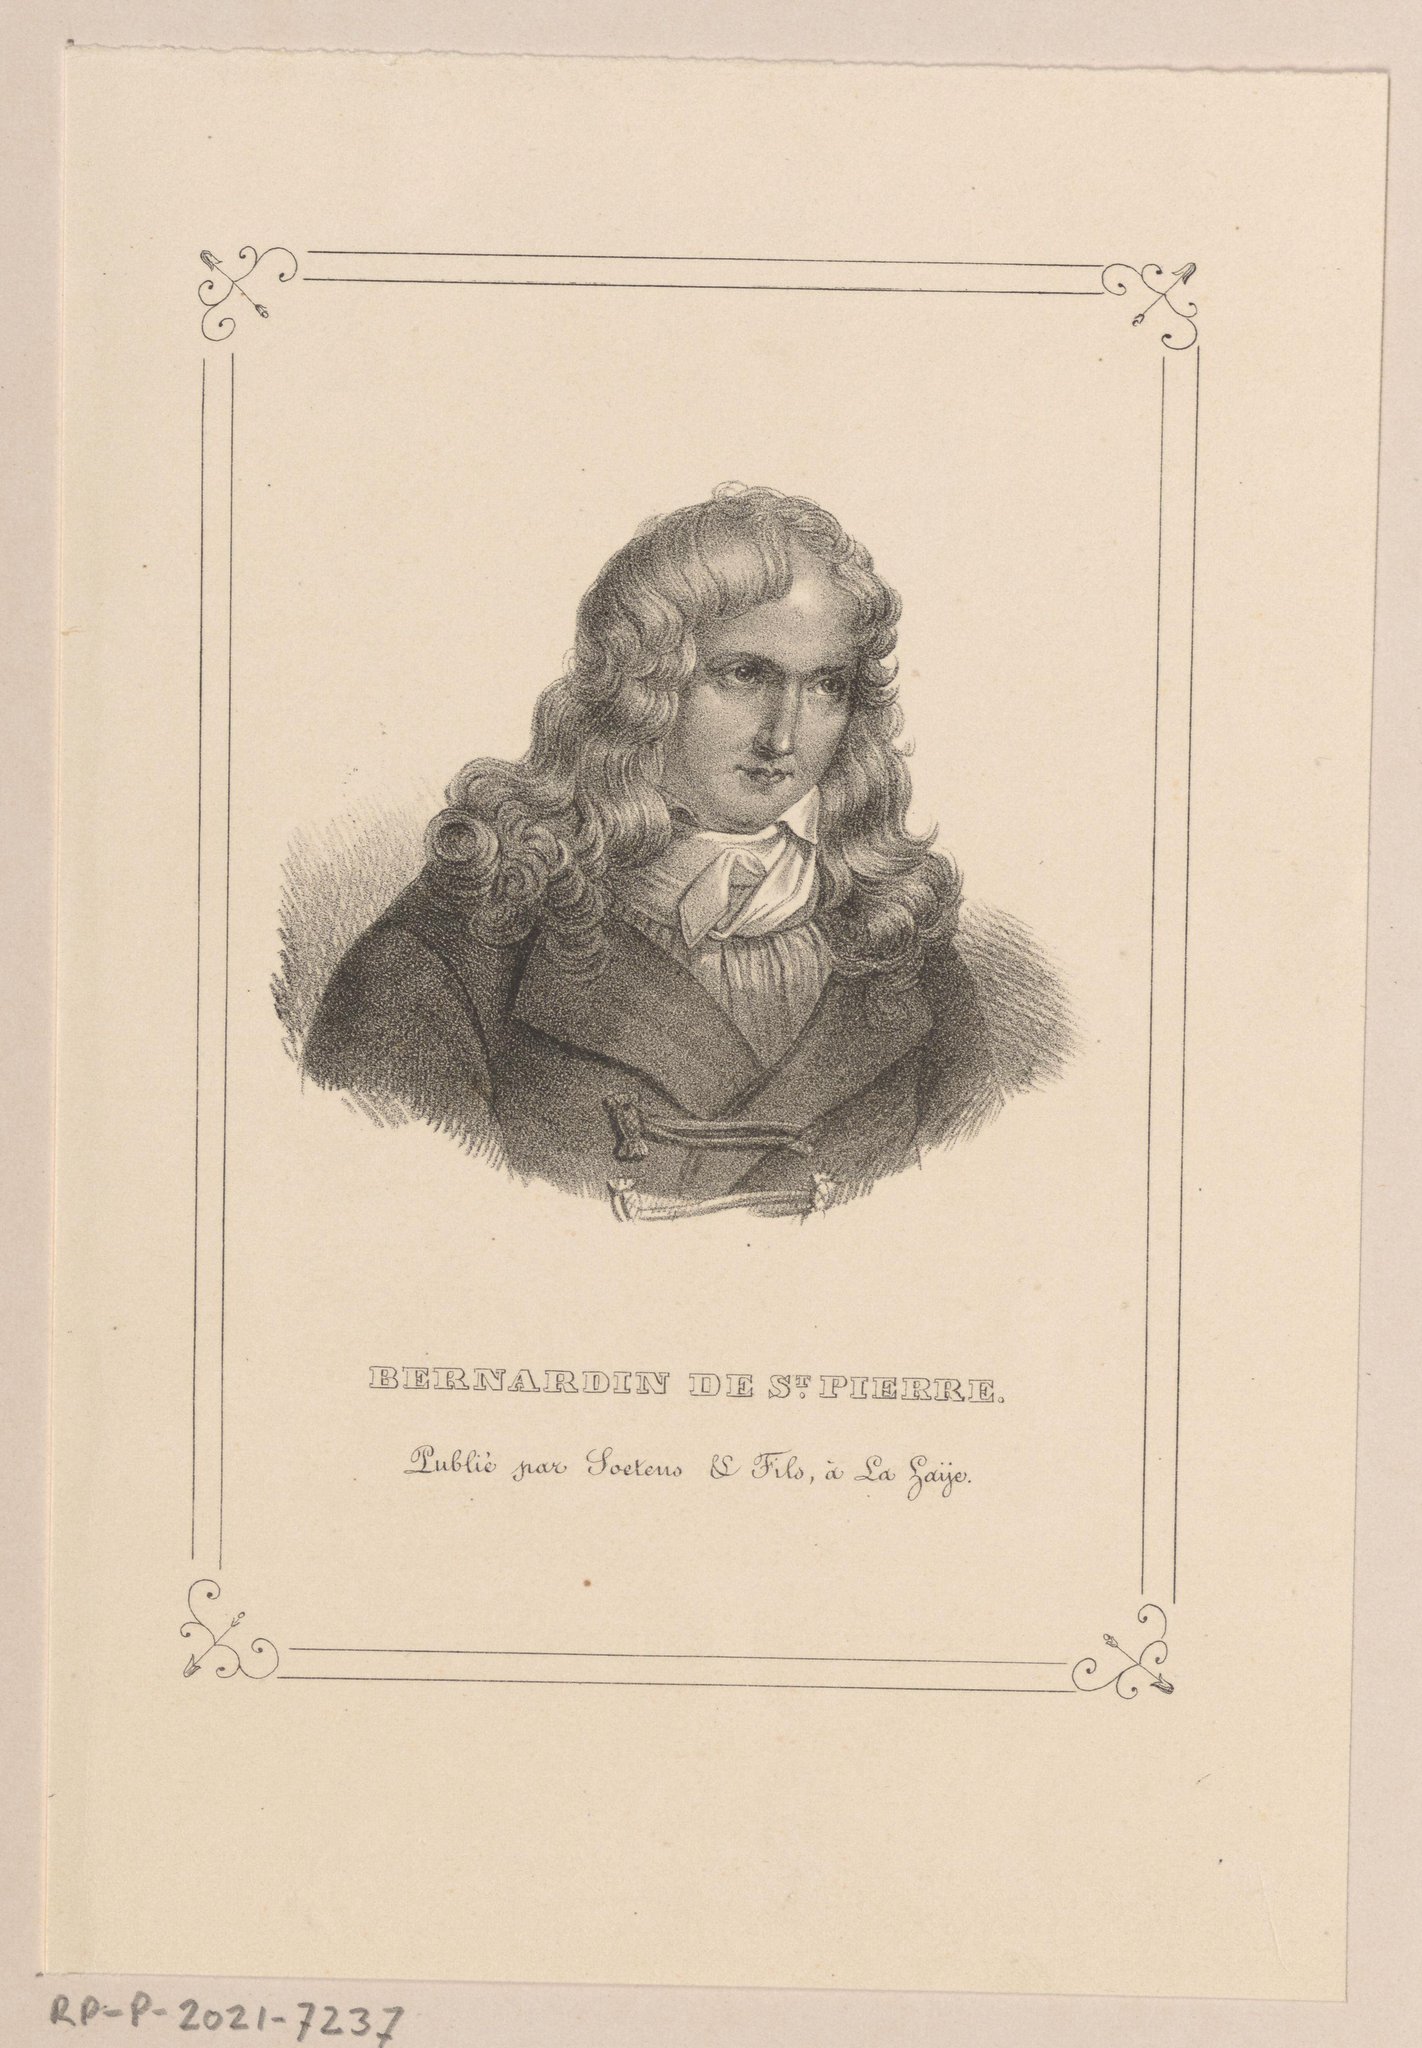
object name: print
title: Portret van Jacques-Henri Bernardin de Saint-Pierre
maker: Anonymous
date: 1837-1840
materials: paper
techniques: lithograph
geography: the hague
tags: historical persons, portrait of a writer, explorer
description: Deze prent maakt mogelijk deel uit van een serie uitgegeven door Soetens et Fils omstreeks 1838, opgedragen aan de Prins van Oranje. In de 'Prospectus en Inteekenlijst' stond vermeld dat de serie bestond uit een onbepaald aantal portretten, waarvan er drie of vier per maand verschenen.